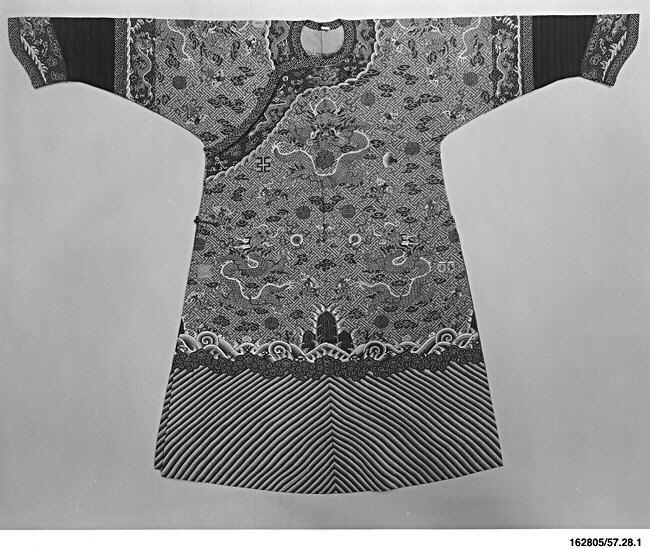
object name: robe, emperor's 12 symbol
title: Empress's Twelve-Symbol Robe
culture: chinese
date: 1909-1911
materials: silk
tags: dragons